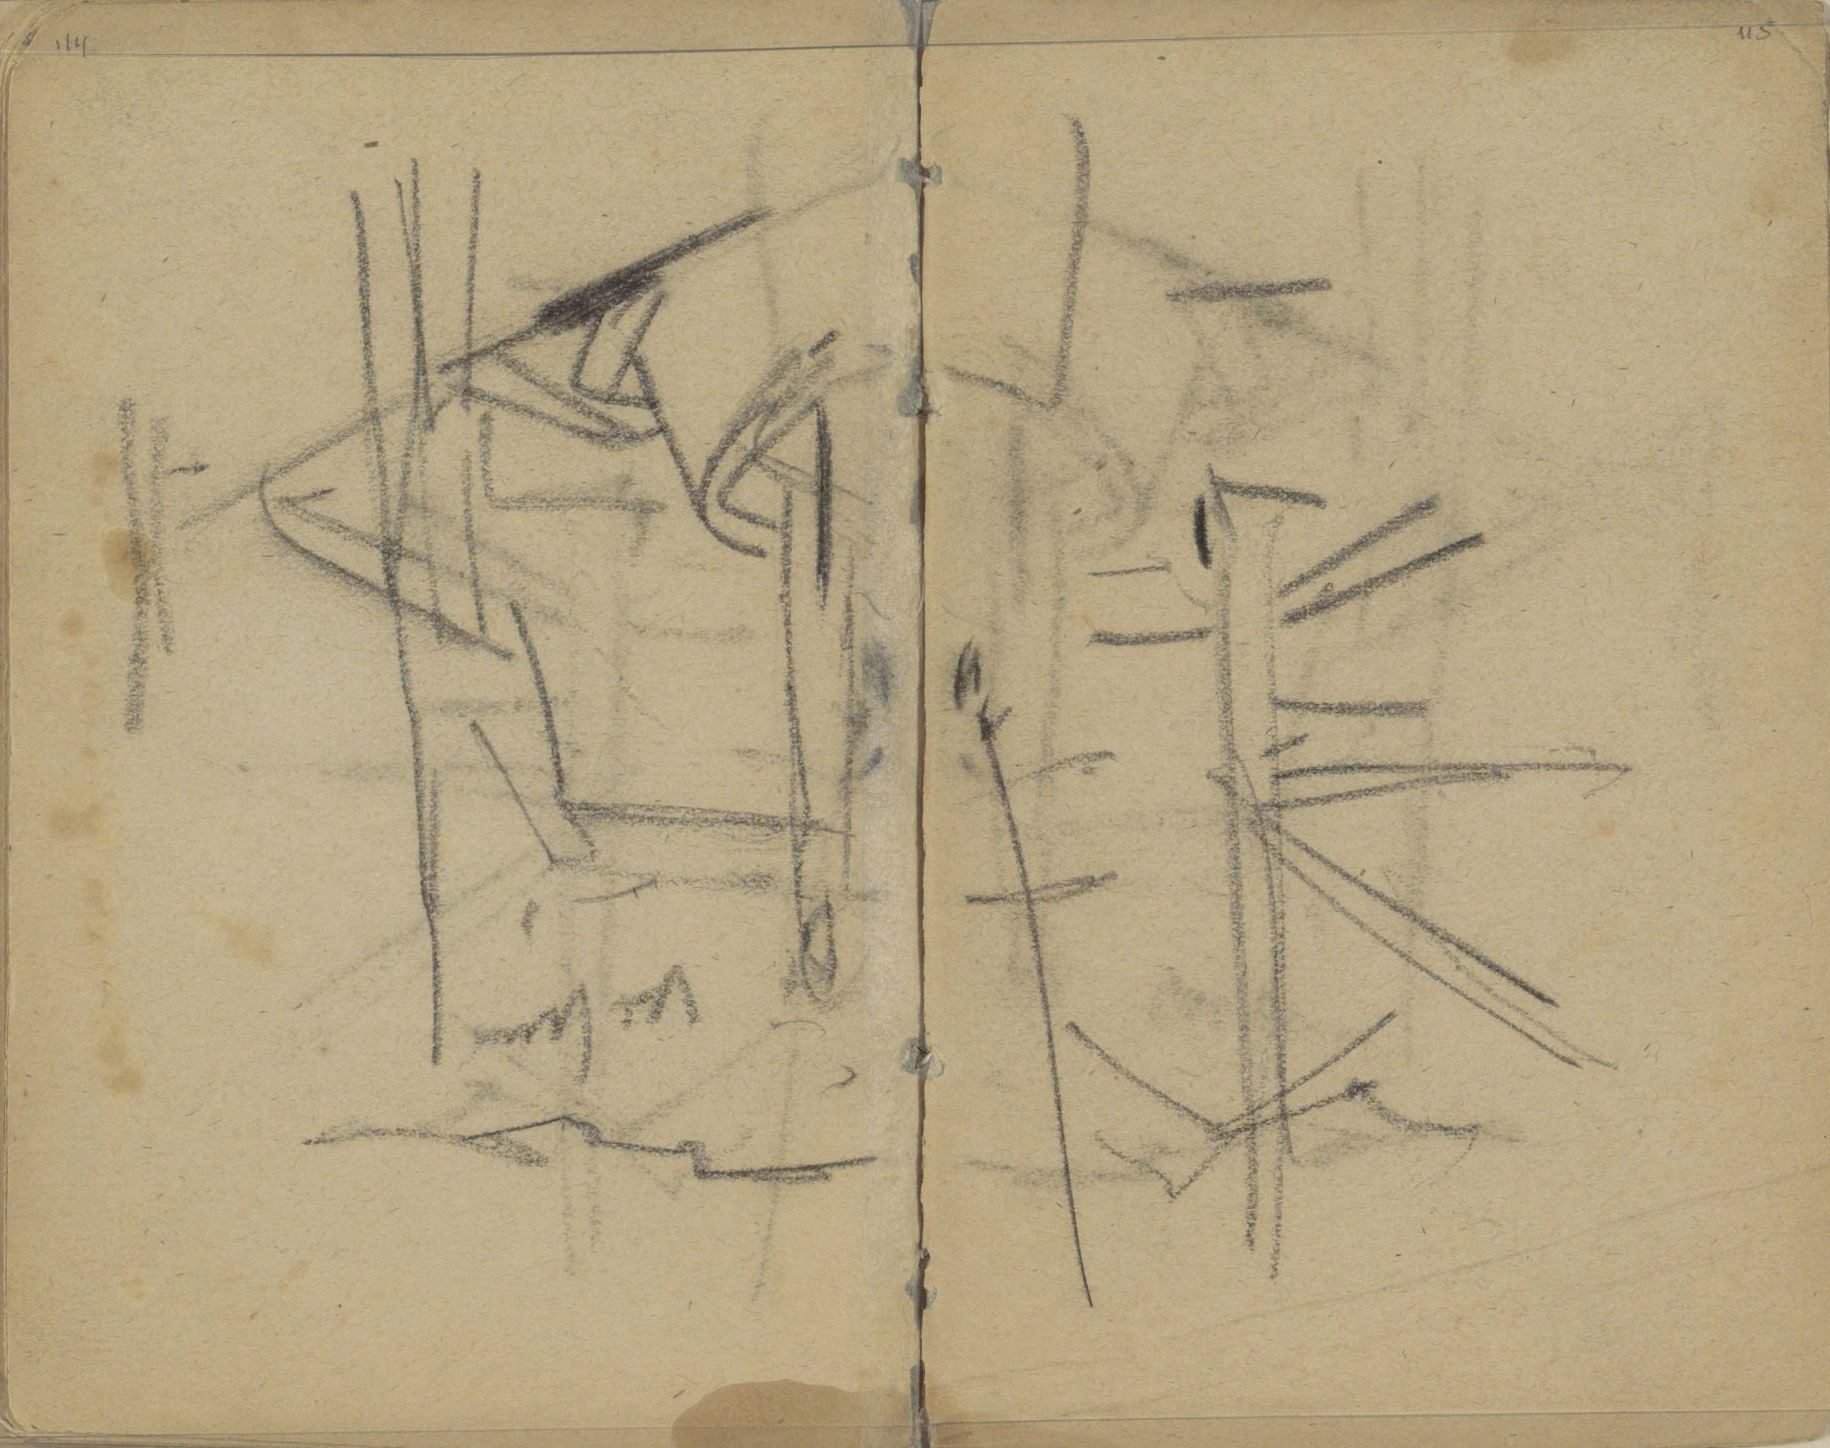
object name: sketchbook leaf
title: Studie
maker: george hendrik breitner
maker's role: draughtsman, painter, print maker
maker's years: 1857-1923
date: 1881-1883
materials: chalk, paper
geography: south holland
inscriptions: annotation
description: Studie. Pagina 114 en pagina 115 uit een schetsboek met 70 bladen.